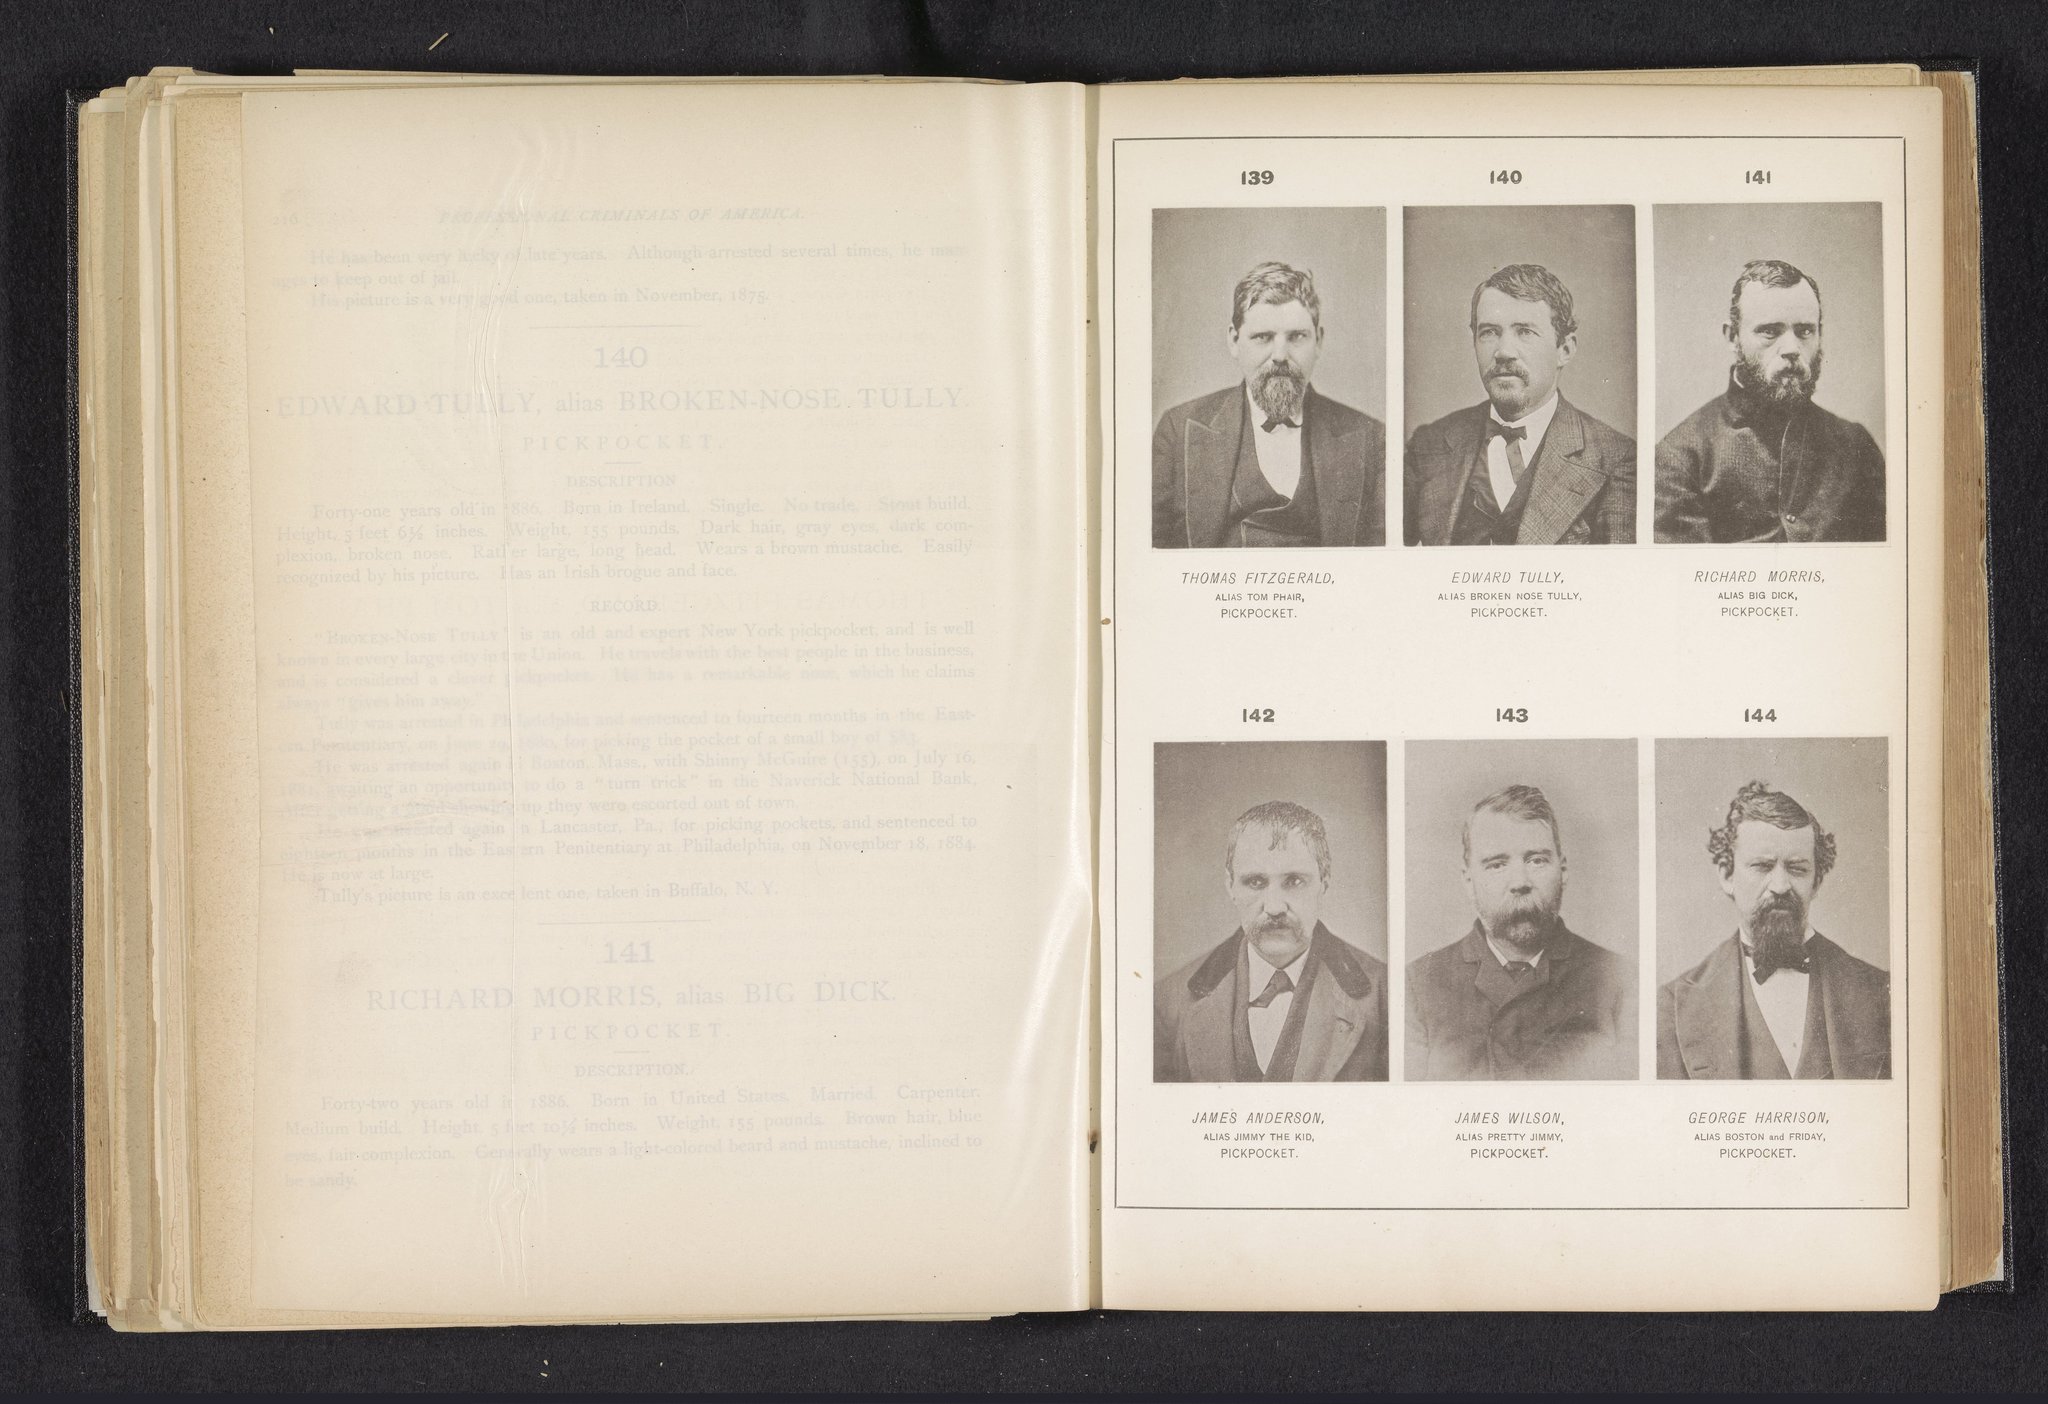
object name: page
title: Zes portretten van zakkenrollers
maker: Anonymous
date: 1881-1886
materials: paper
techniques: photograph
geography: boston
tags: historical persons not known by name (+ (full) bust portrait), pickpocket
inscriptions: inscription: ‘Thomas Fitzgerald (...) pickpocket.’, number: ‘139 (...) 144’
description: Linksboven Thomas Fitzgerald, midden boven Edward Tully, rechtsboven Richard Morris, linksonder James Anderson, midden onder James Wilson, rechtsonder George Harrison.